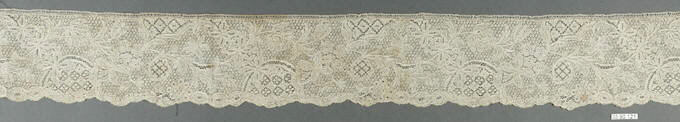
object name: edging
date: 1701-1733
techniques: lace